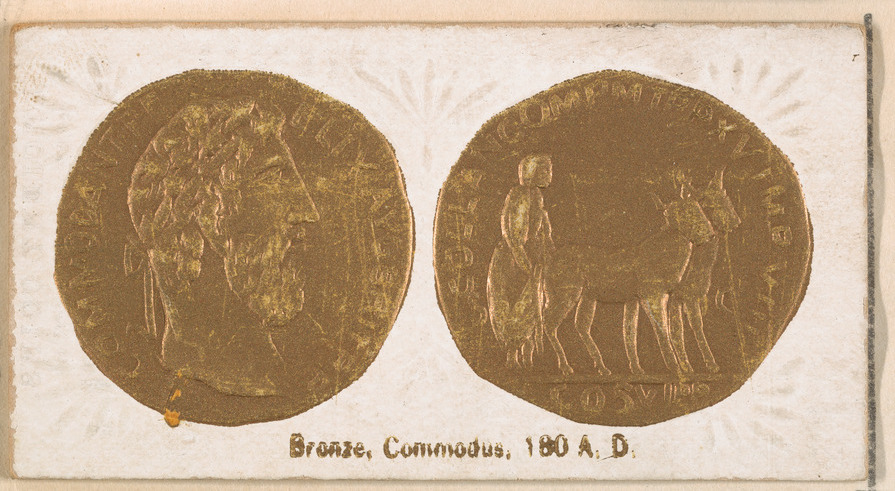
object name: print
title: Bronze, Commodus, 180 A.D., from the Ancient Coins series (N180) issued by Wm. S. Kimball & Co.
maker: william s. kimball & company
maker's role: publisher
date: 1888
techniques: color lithograph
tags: coins